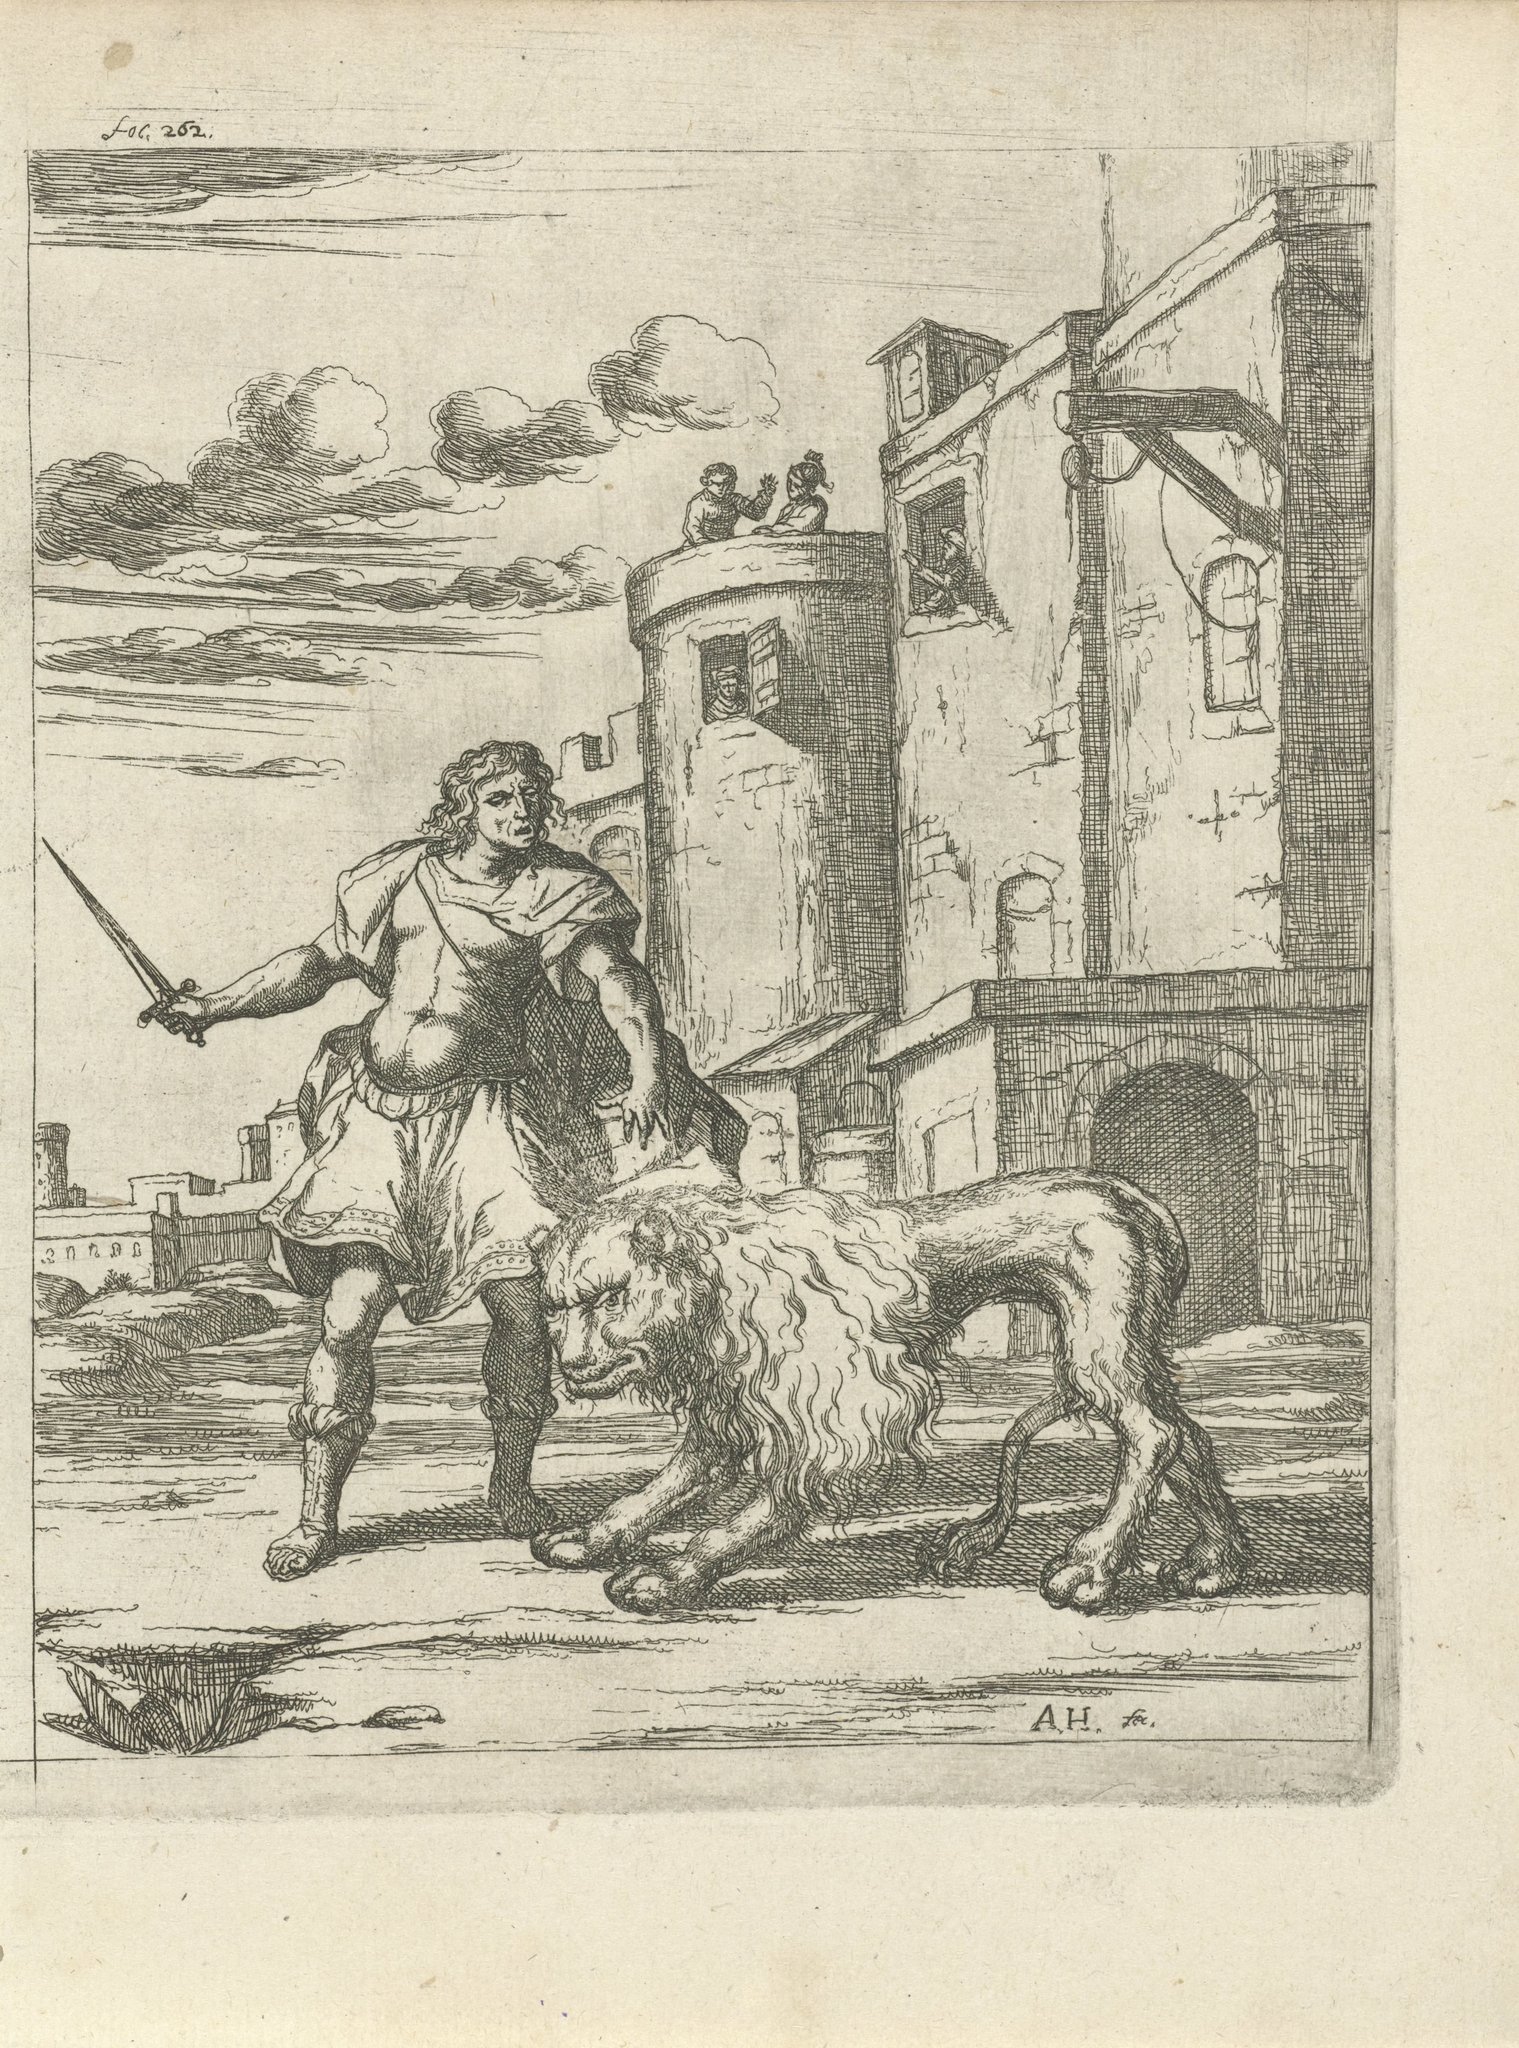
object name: print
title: Hendrik, graaf van Holstein temt een leeuw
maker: arnold houbraken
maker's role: draughtsman, painter, print maker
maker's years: 1660-1719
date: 1681-1683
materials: paper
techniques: etching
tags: walls ~ fortified city, beasts of prey, predatory animals: lion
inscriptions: collector's mark: Lugt 2228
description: Een krijgsheer met in zijn rechterhand een steekwapen bij een leeuw, met stadsmuren op de achtergrond. Linksboven: fol. 262. Prent gebruikt in een boek van Lambert van den Bos met in totaal twintig prenten van Arnold Houbraken.